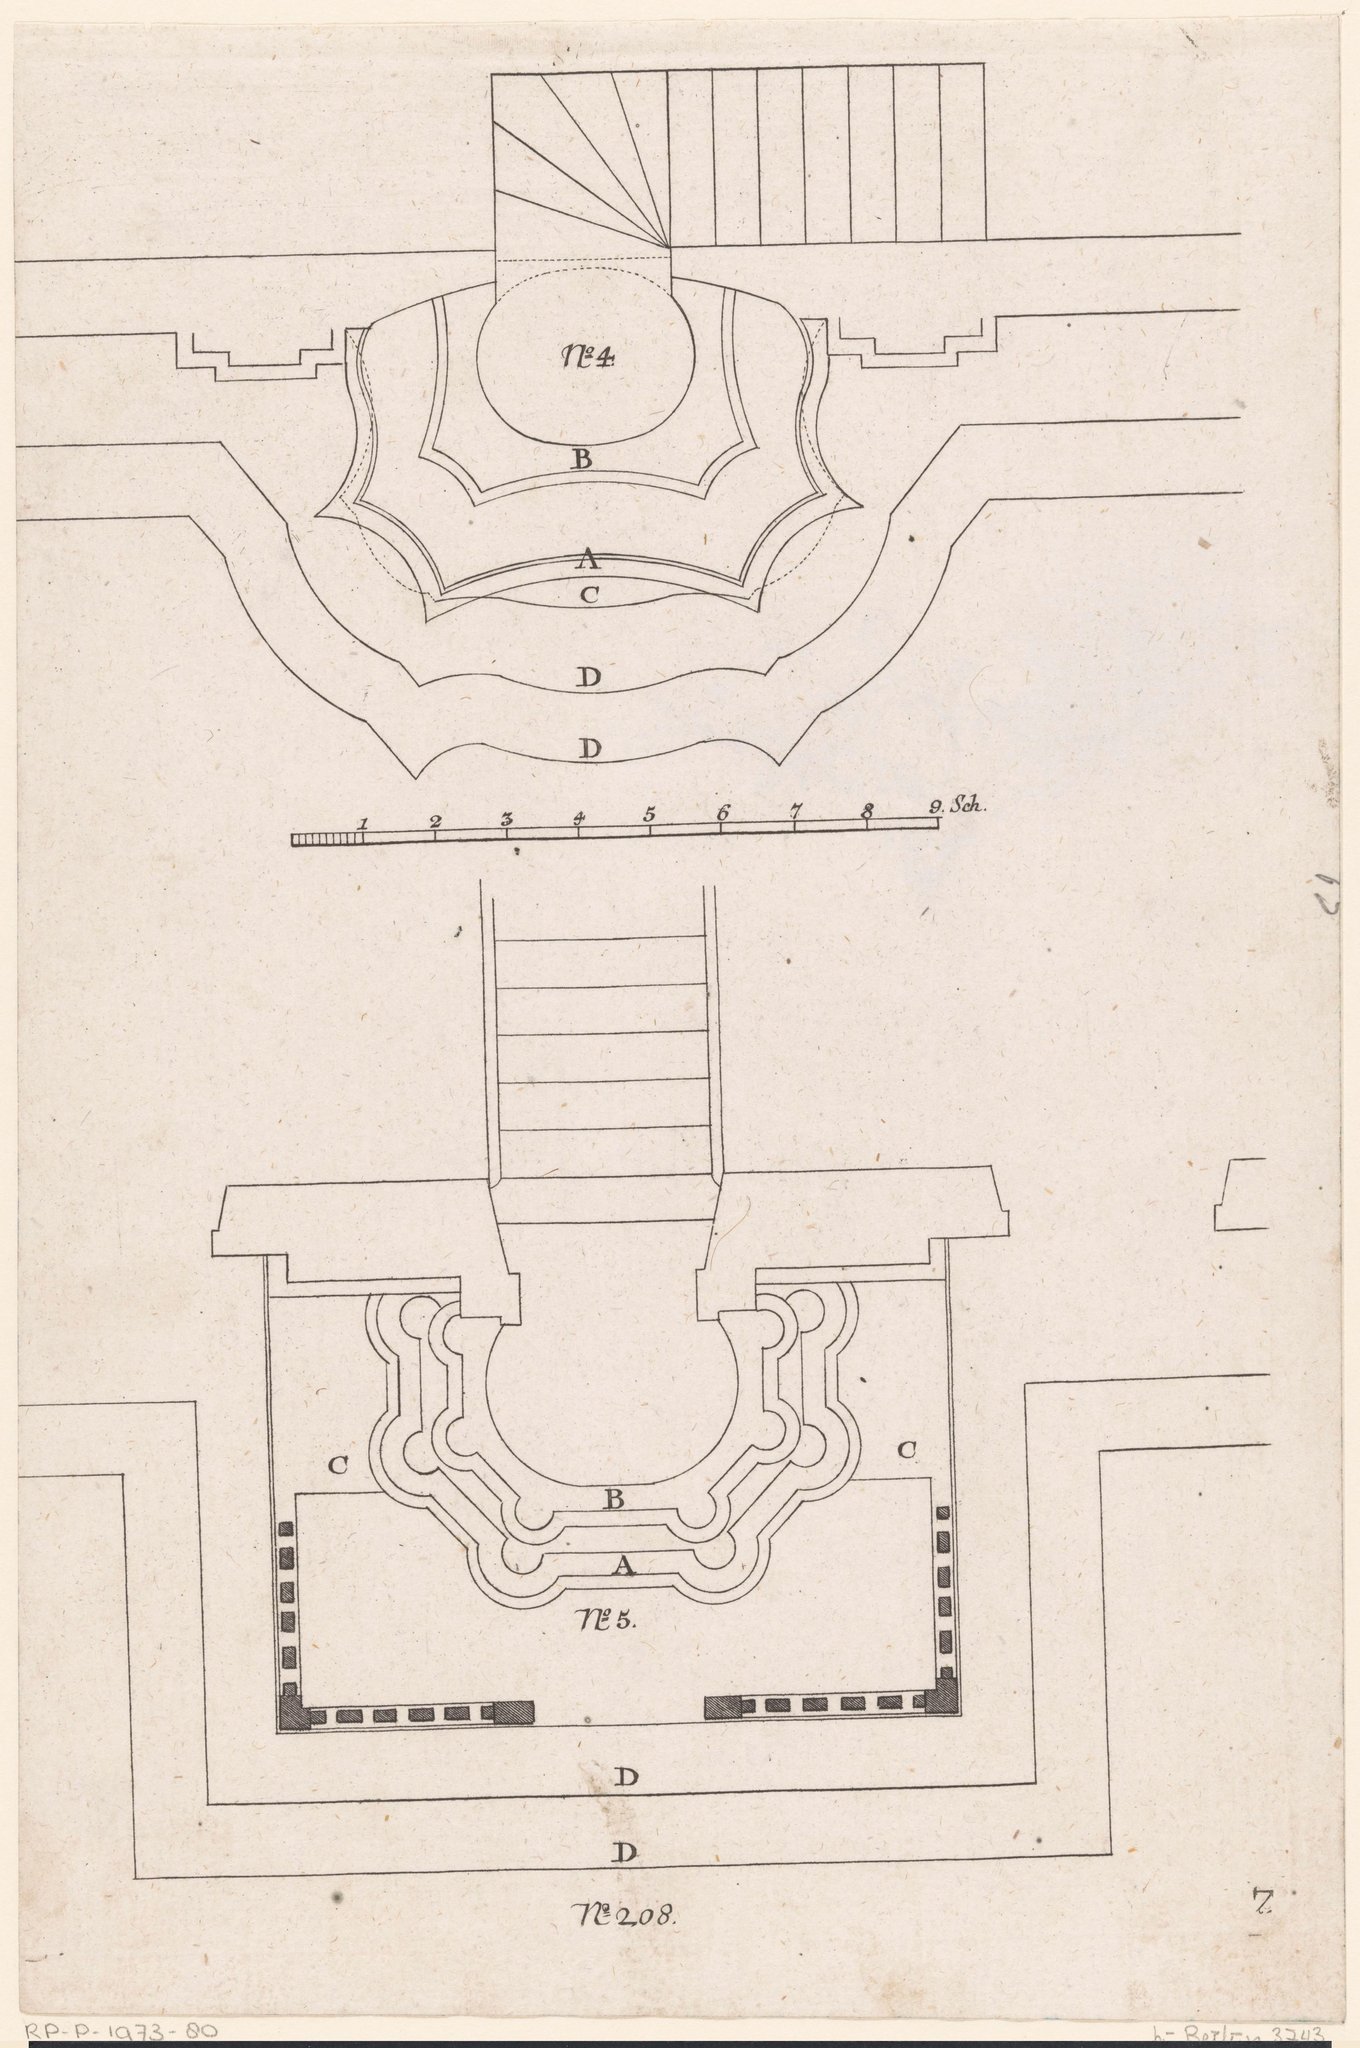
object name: print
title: Plattegronden van twee kanselaltaren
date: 1705-1775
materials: paper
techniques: engraving, etching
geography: augsburg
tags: architectural design or model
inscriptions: collector's mark: Lugt 2760, collector's mark: Lugt 2228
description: Plattegronden van nummer 4 en 5. Uitgeversnummer 208.